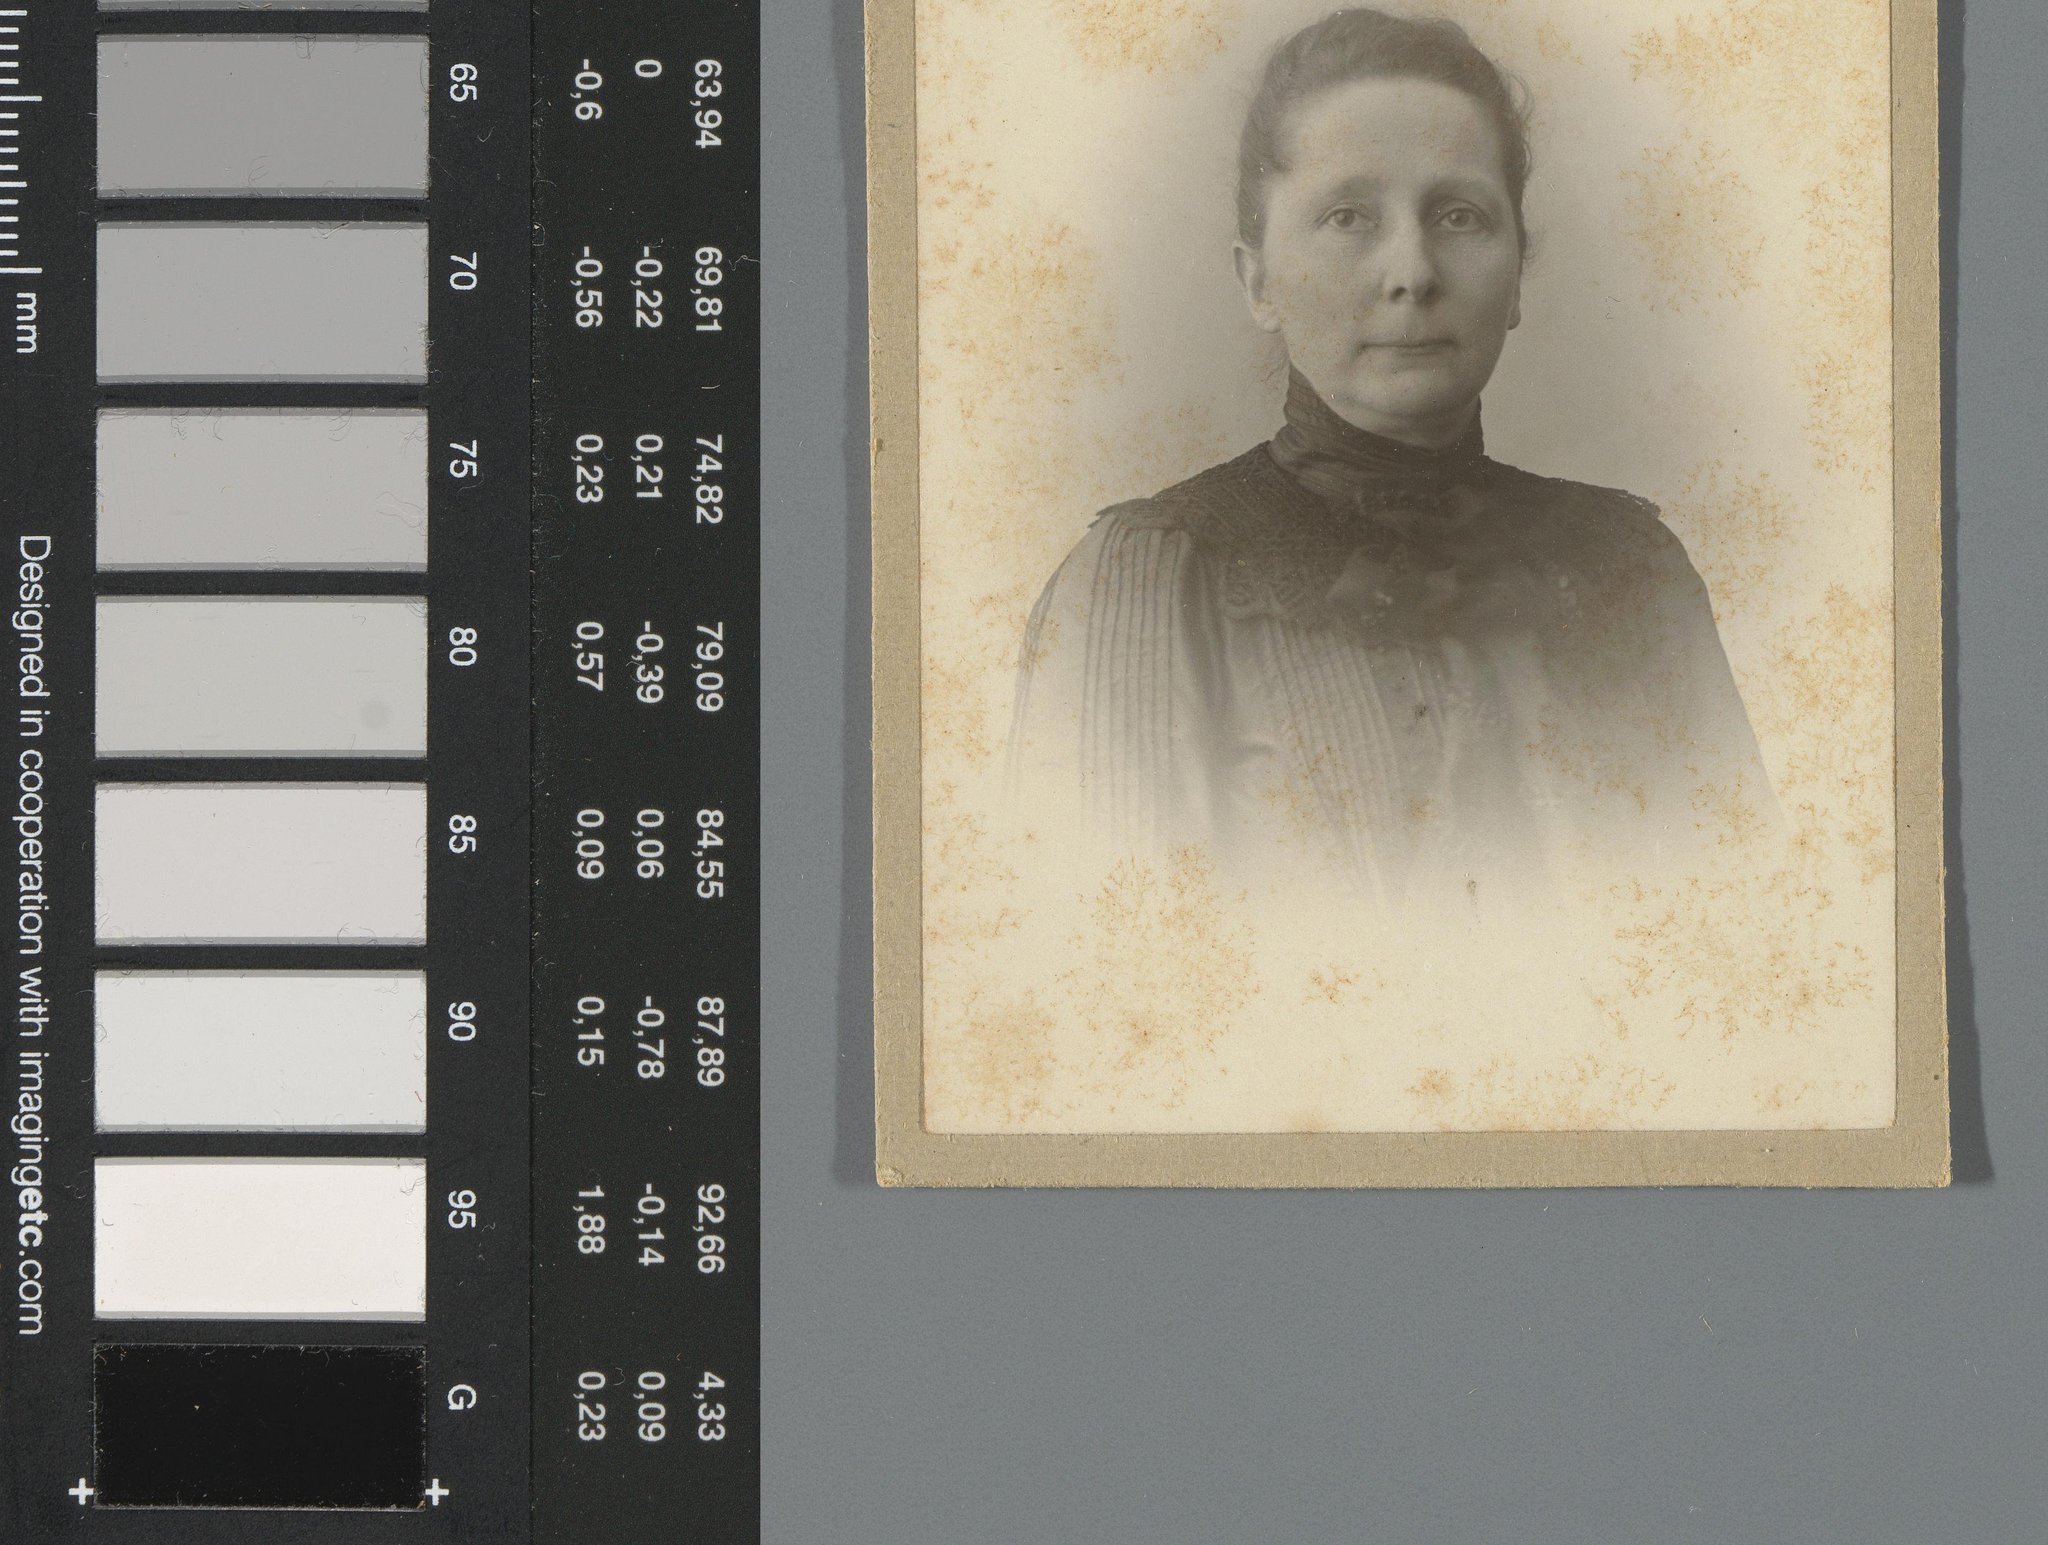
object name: carte de visite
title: Portret van Goverta Teding van Berkhout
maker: Anonymous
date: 1886-1920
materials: cardboard, photographic support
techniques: photography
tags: haarlem, historical persons - bb - woman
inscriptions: annotation: ‘G. Haitsma Mulier TvB’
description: Portret van Goverta Haitsma Mulier-Teding van Berkhout.